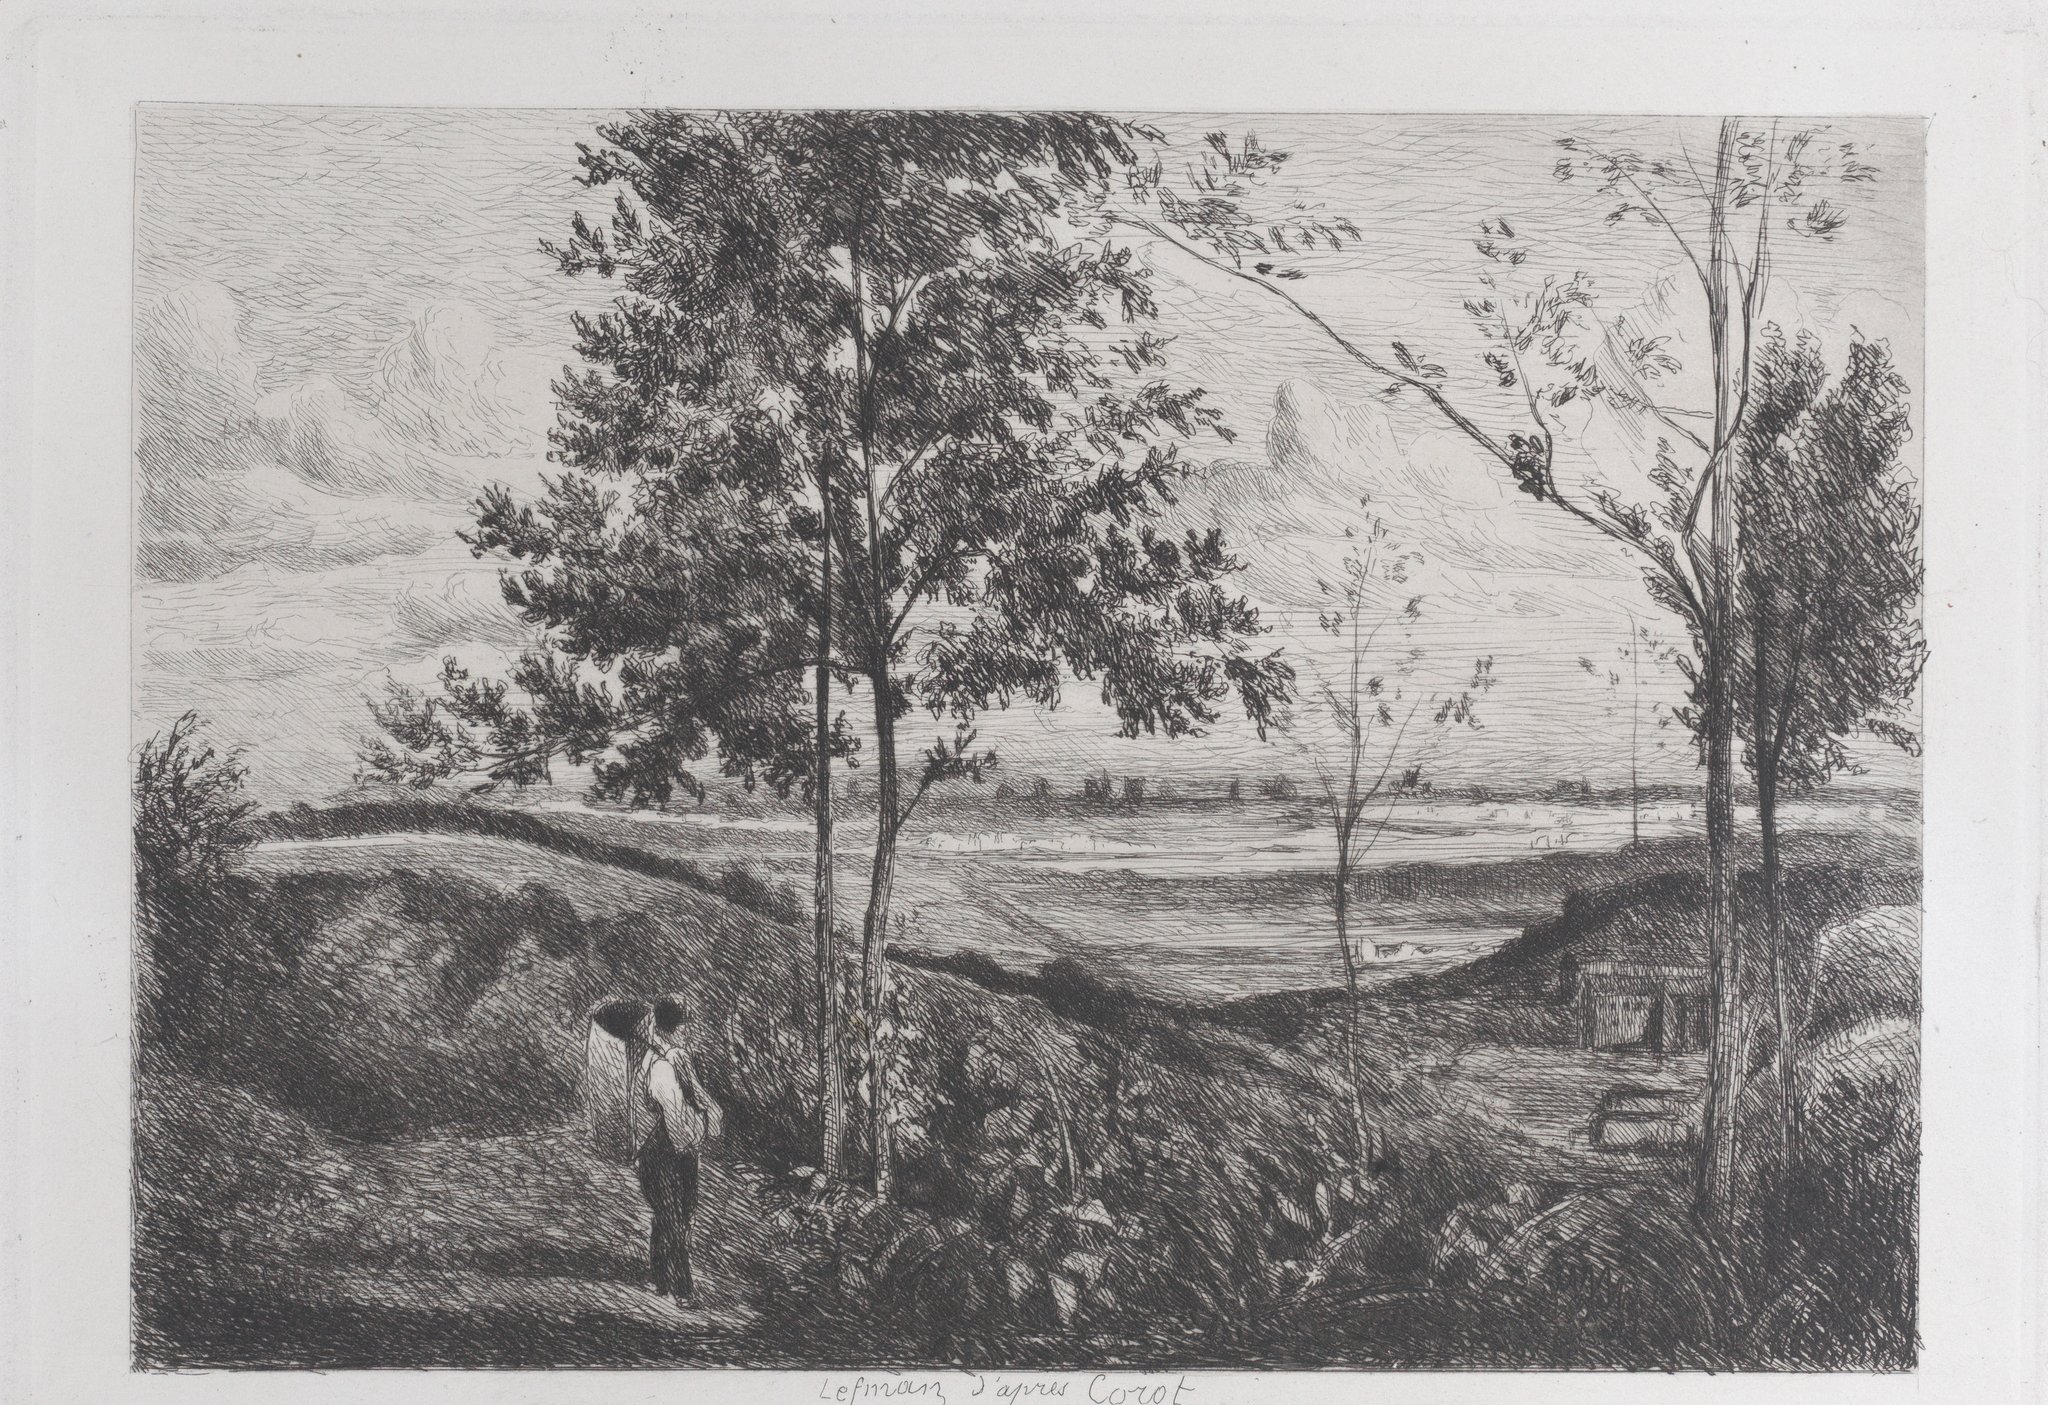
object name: print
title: Landscape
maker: ferdinand lefman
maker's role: artist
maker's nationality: french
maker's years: 1873-1890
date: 1873-1890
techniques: etching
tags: men,landscapes,trees